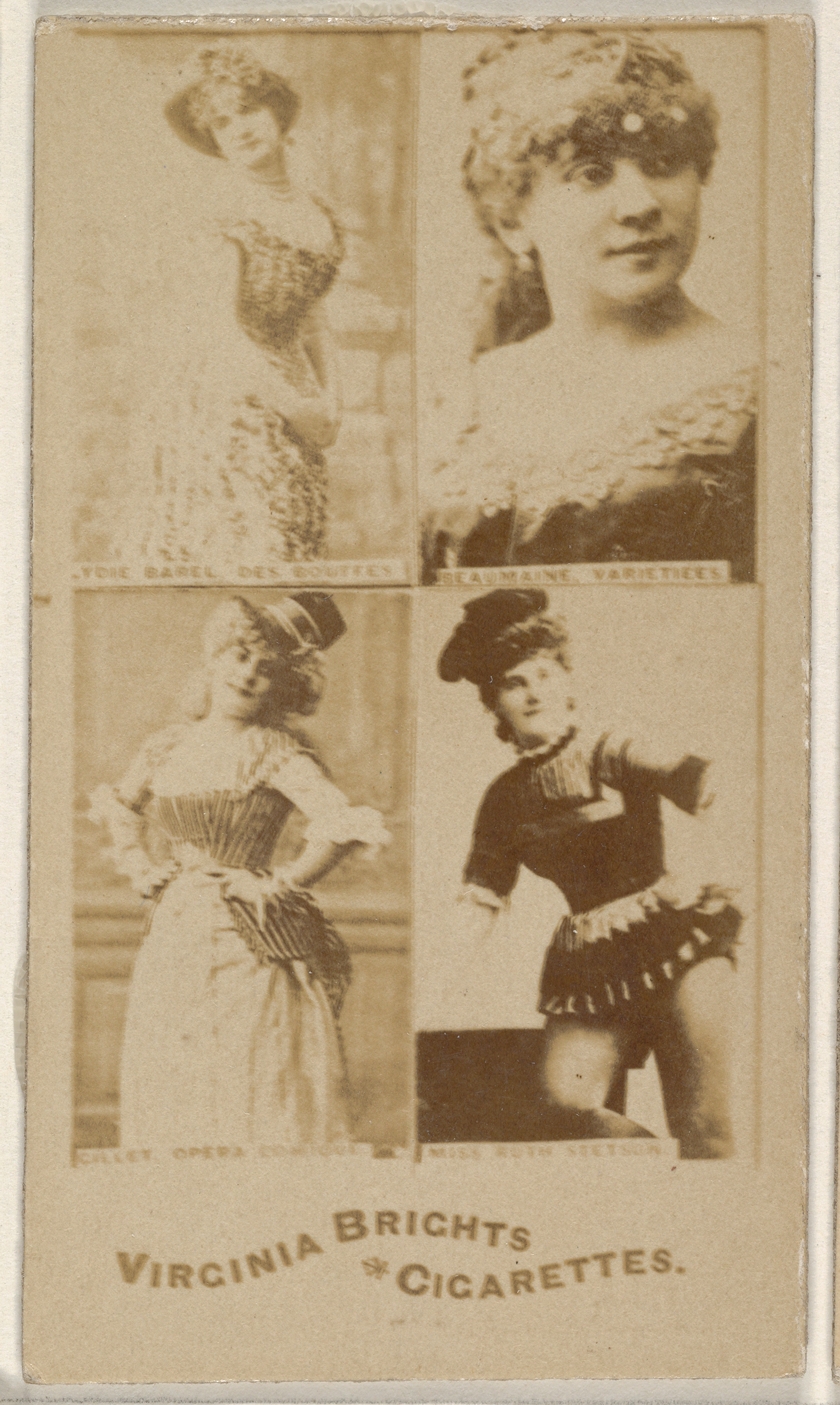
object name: photograph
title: Beaumaine, Variettees/ Callet, Opera Comique/ Miss Ruth Stetson, from the Actors and Actresses series (N45, Type 4) for Virginia Brights Cigarettes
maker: allen & ginter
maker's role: publisher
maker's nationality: american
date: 1888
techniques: albumen silver print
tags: portraits,women,actresses